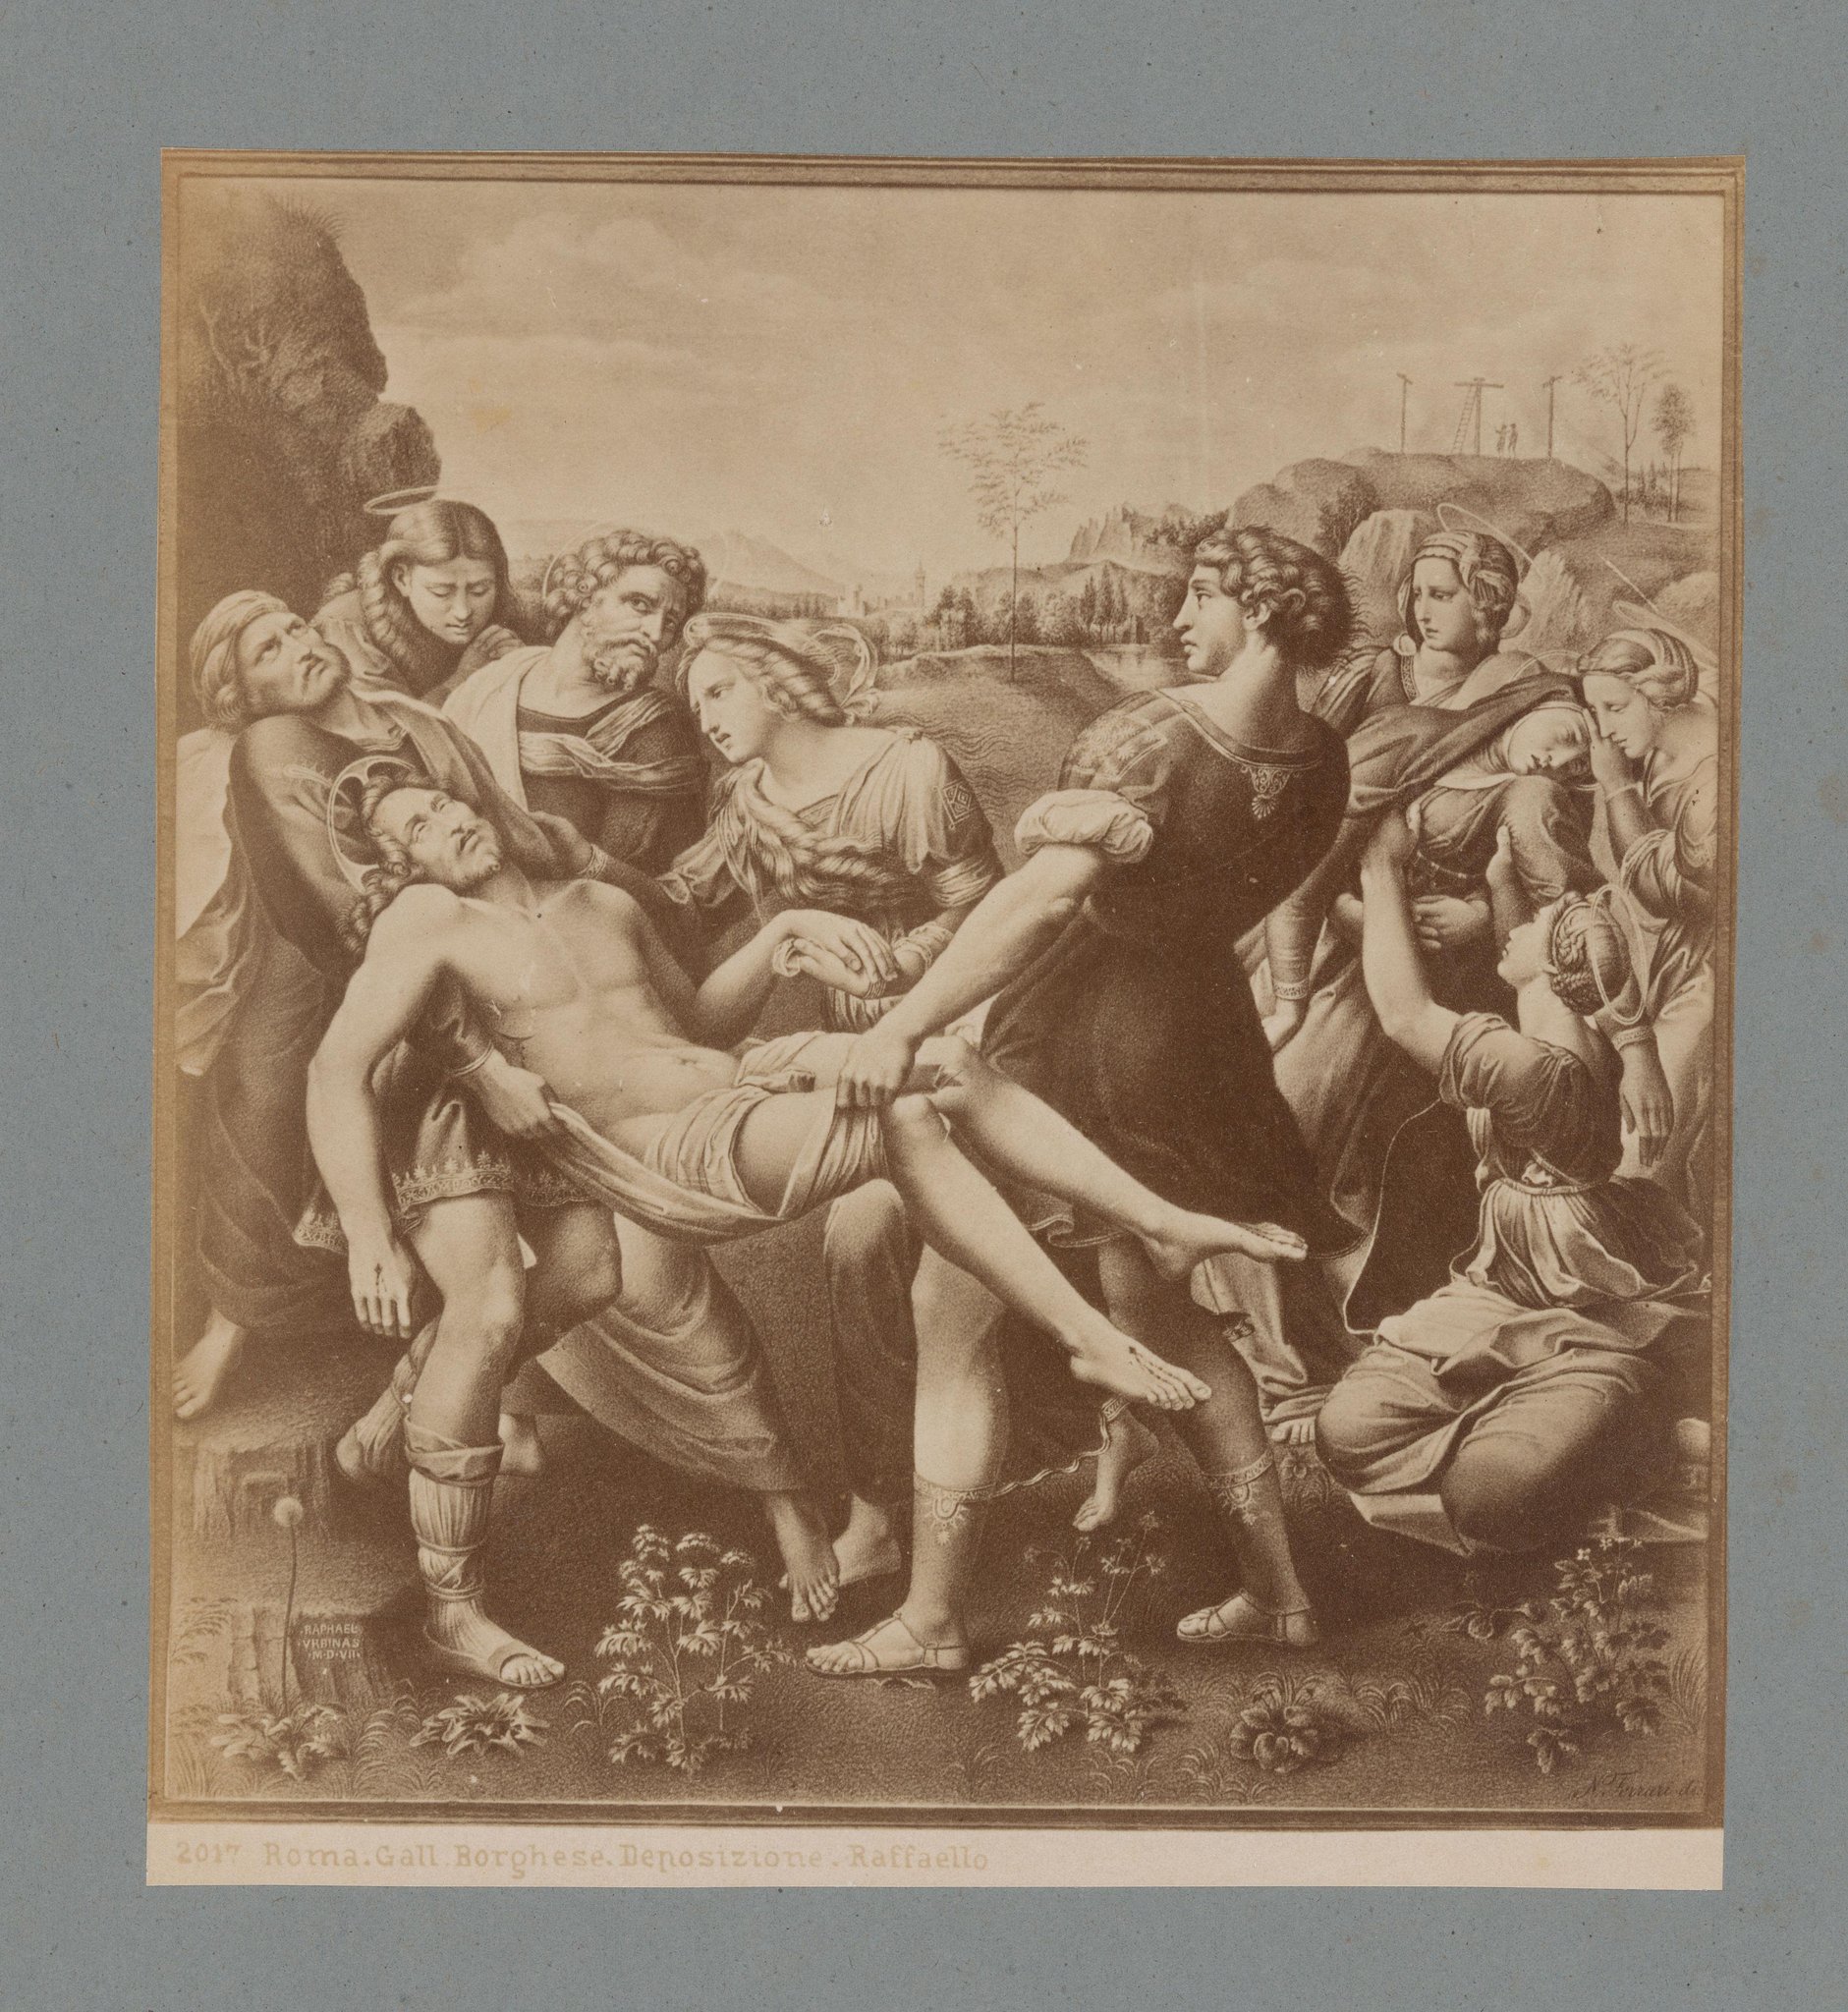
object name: photograph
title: Fotoreproductie van het schilderij Kruisafname door Rafaël, in de collectie van de Galleria Borghese te Rome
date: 1851-1900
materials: cardboard, paper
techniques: albumen print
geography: rome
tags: drawing, sketch, picture, painting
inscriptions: collector's mark: ‘VOSMAER’, number: ‘2017’